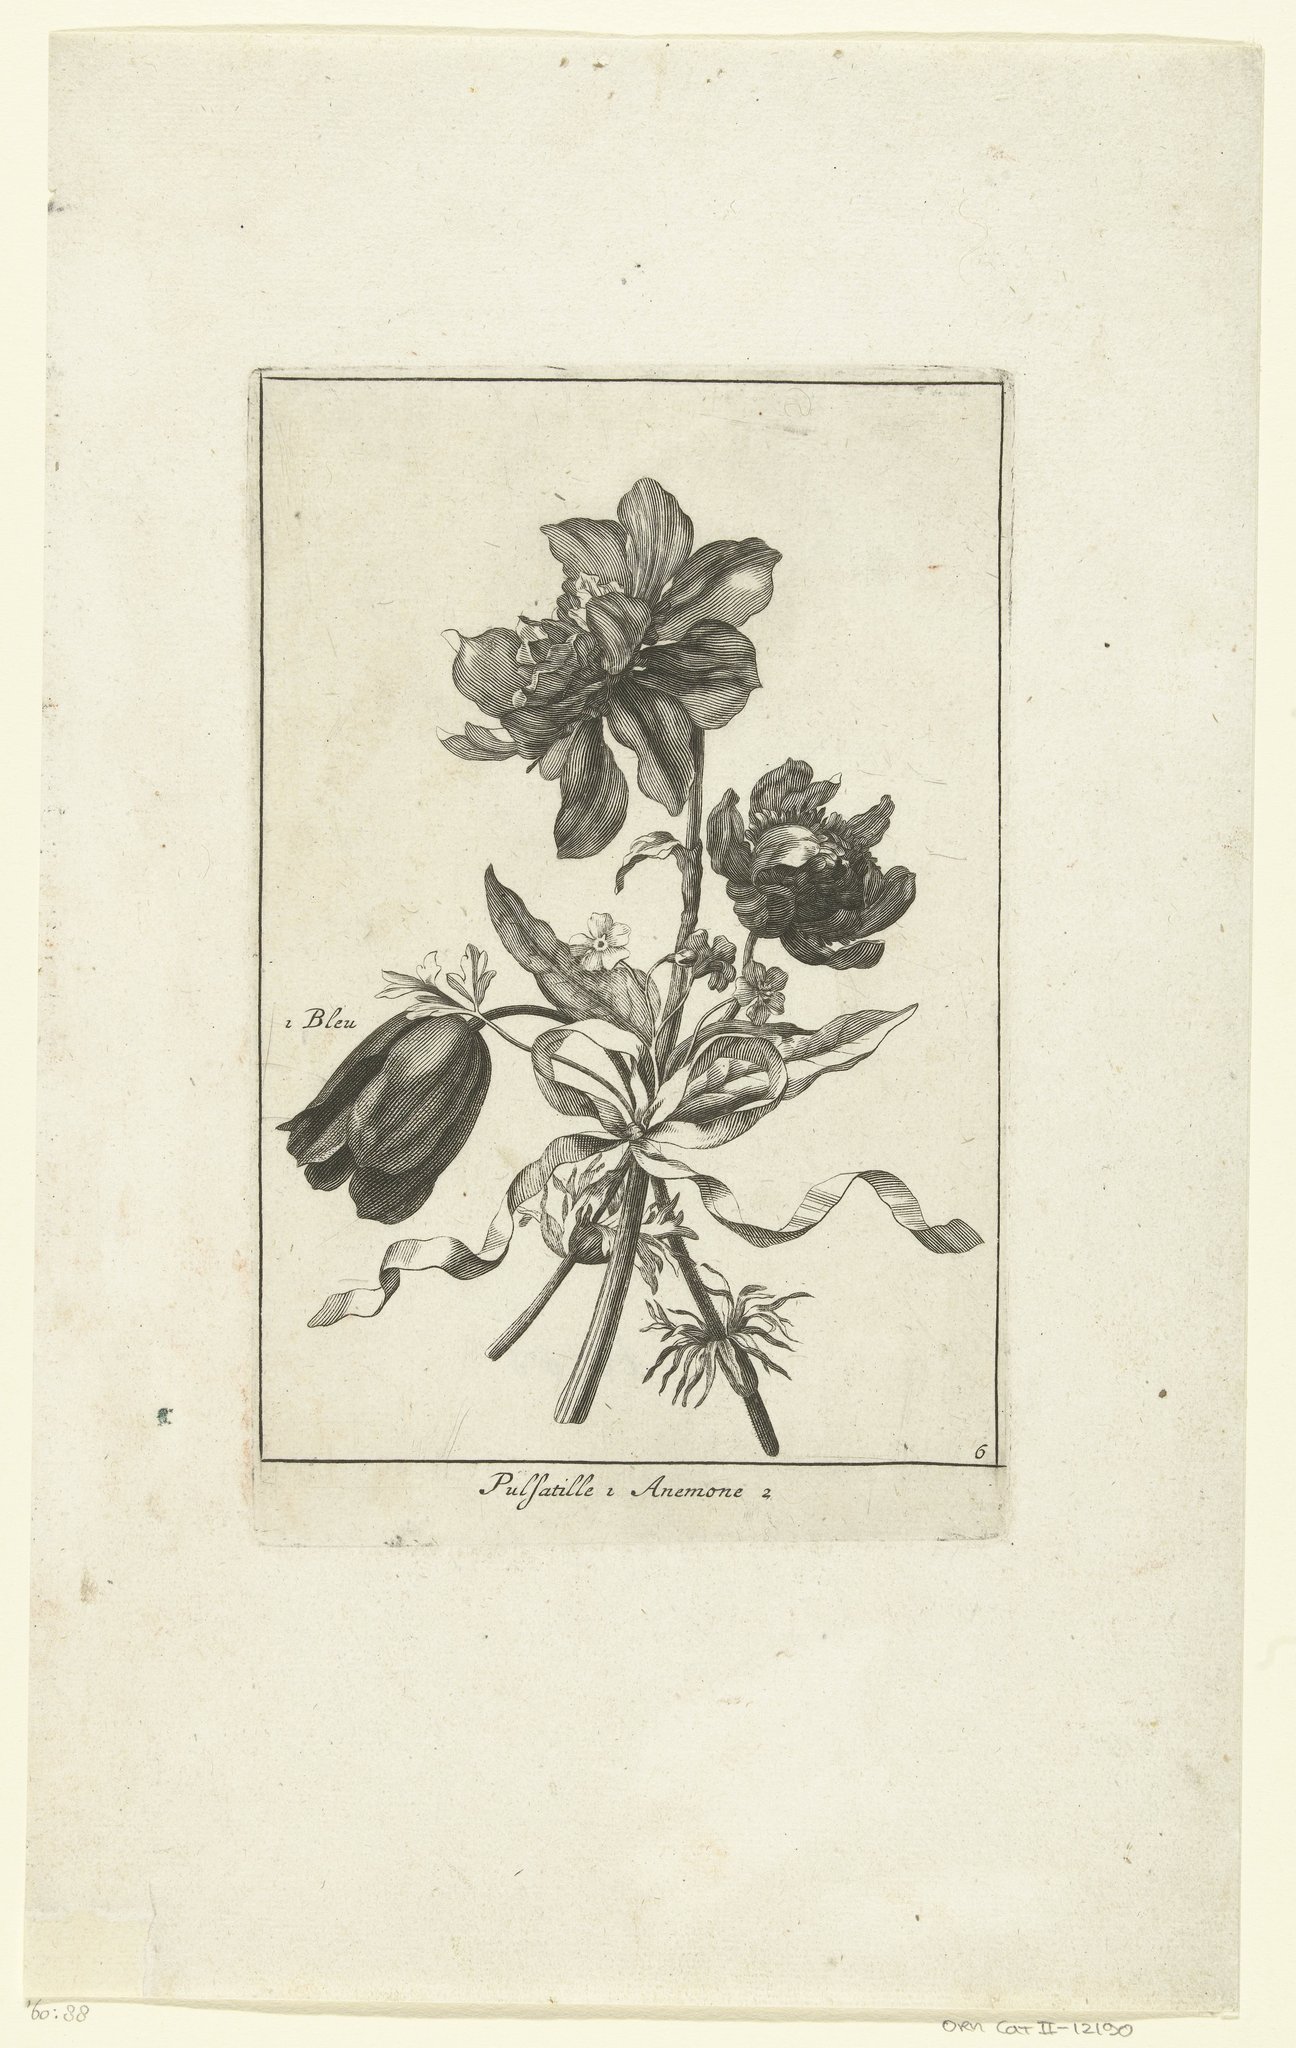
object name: ornament print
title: Bloemen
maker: Anonymous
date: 1700-1800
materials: paper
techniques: engraving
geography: netherlands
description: De serie bestaat uit bloemen die zijn samengebonden in boeketten, onderaan staan de namen van de bloemen.